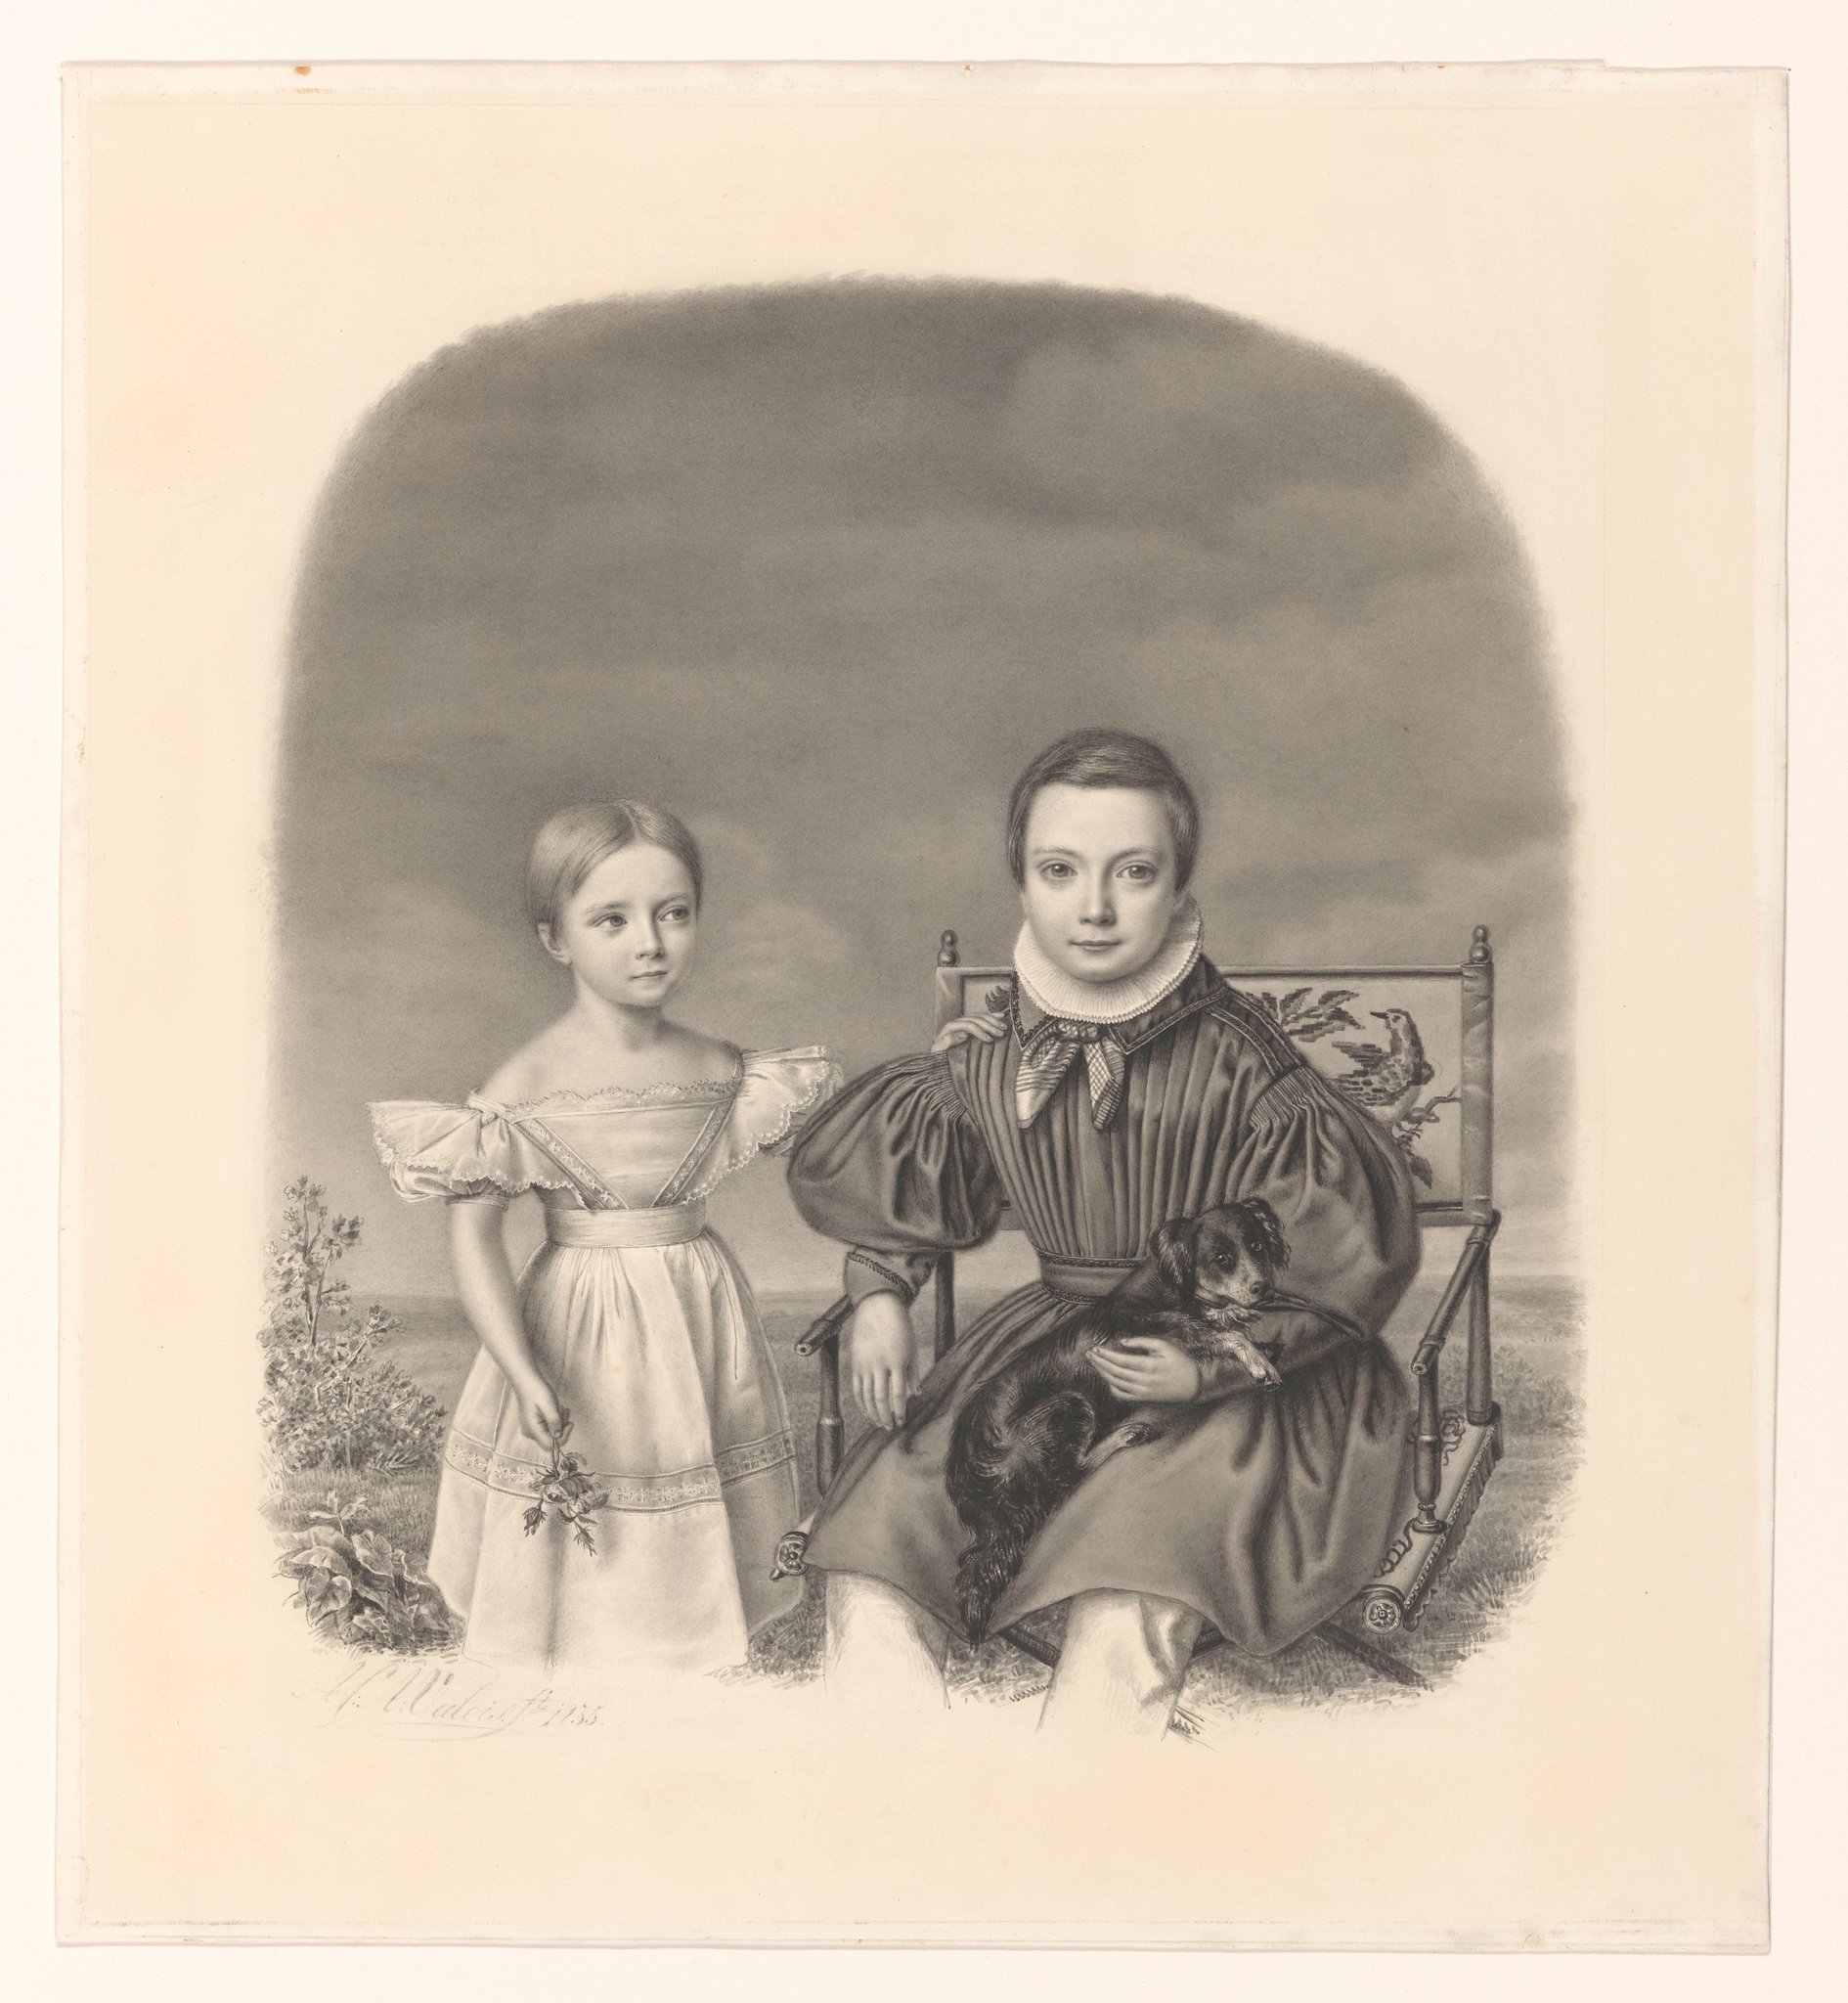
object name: drawing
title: Portret van Willem Anne baron van Constant Rebecque de Villars en zijn zus Clara Margaretha Francesca van Constant Rebecque de Villars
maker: alexander cesar august valois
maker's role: draughtsman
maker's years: 1812-1876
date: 1835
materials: paper, pencil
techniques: stumping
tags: the hague, historical persons - bb - woman, historical persons, chair, brothers or sisters (second degree family relationships), dog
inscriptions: date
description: De jongen zit op een stoel met een hondje op schoot. Naast hem staat zijn zus. Een vlak landschap als achtergrond.